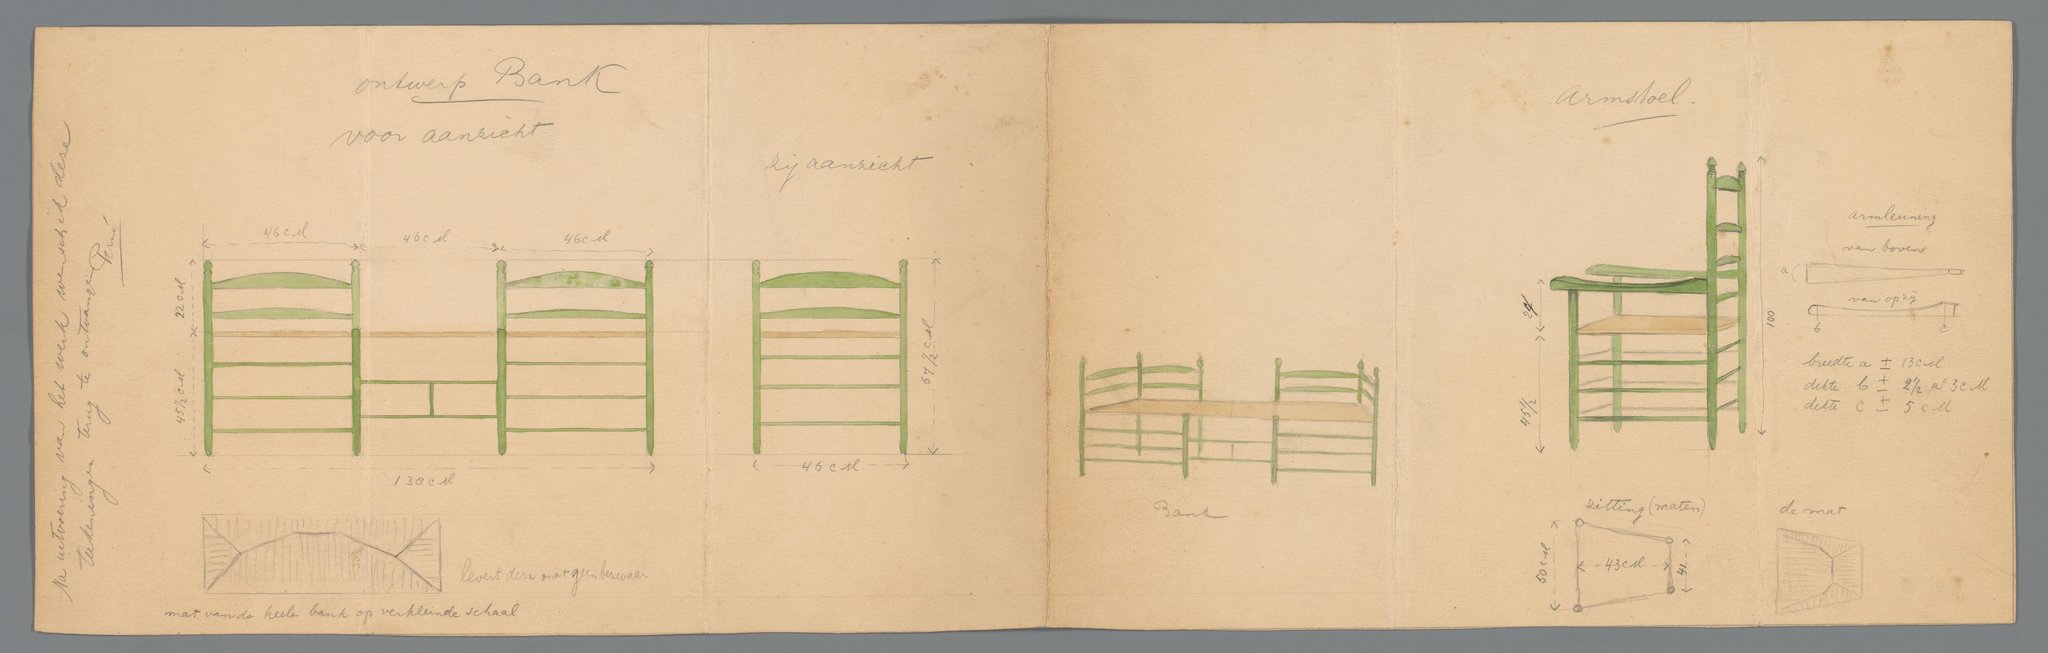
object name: design drawing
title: Ontwerp voor een bank en een stoel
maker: gust van de wall perné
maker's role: draughtsman, painter, print maker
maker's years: 1877-1911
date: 1887-1911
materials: paper, pencil, watercolor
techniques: brush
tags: chair, couch, sofa, settee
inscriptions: inscription: ‘ontwerp Bank / Armstoel’, collector's mark: Lugt 2228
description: Voor-, zij- en bovenaanzicht. Met aantekeningen over de afmetingen.